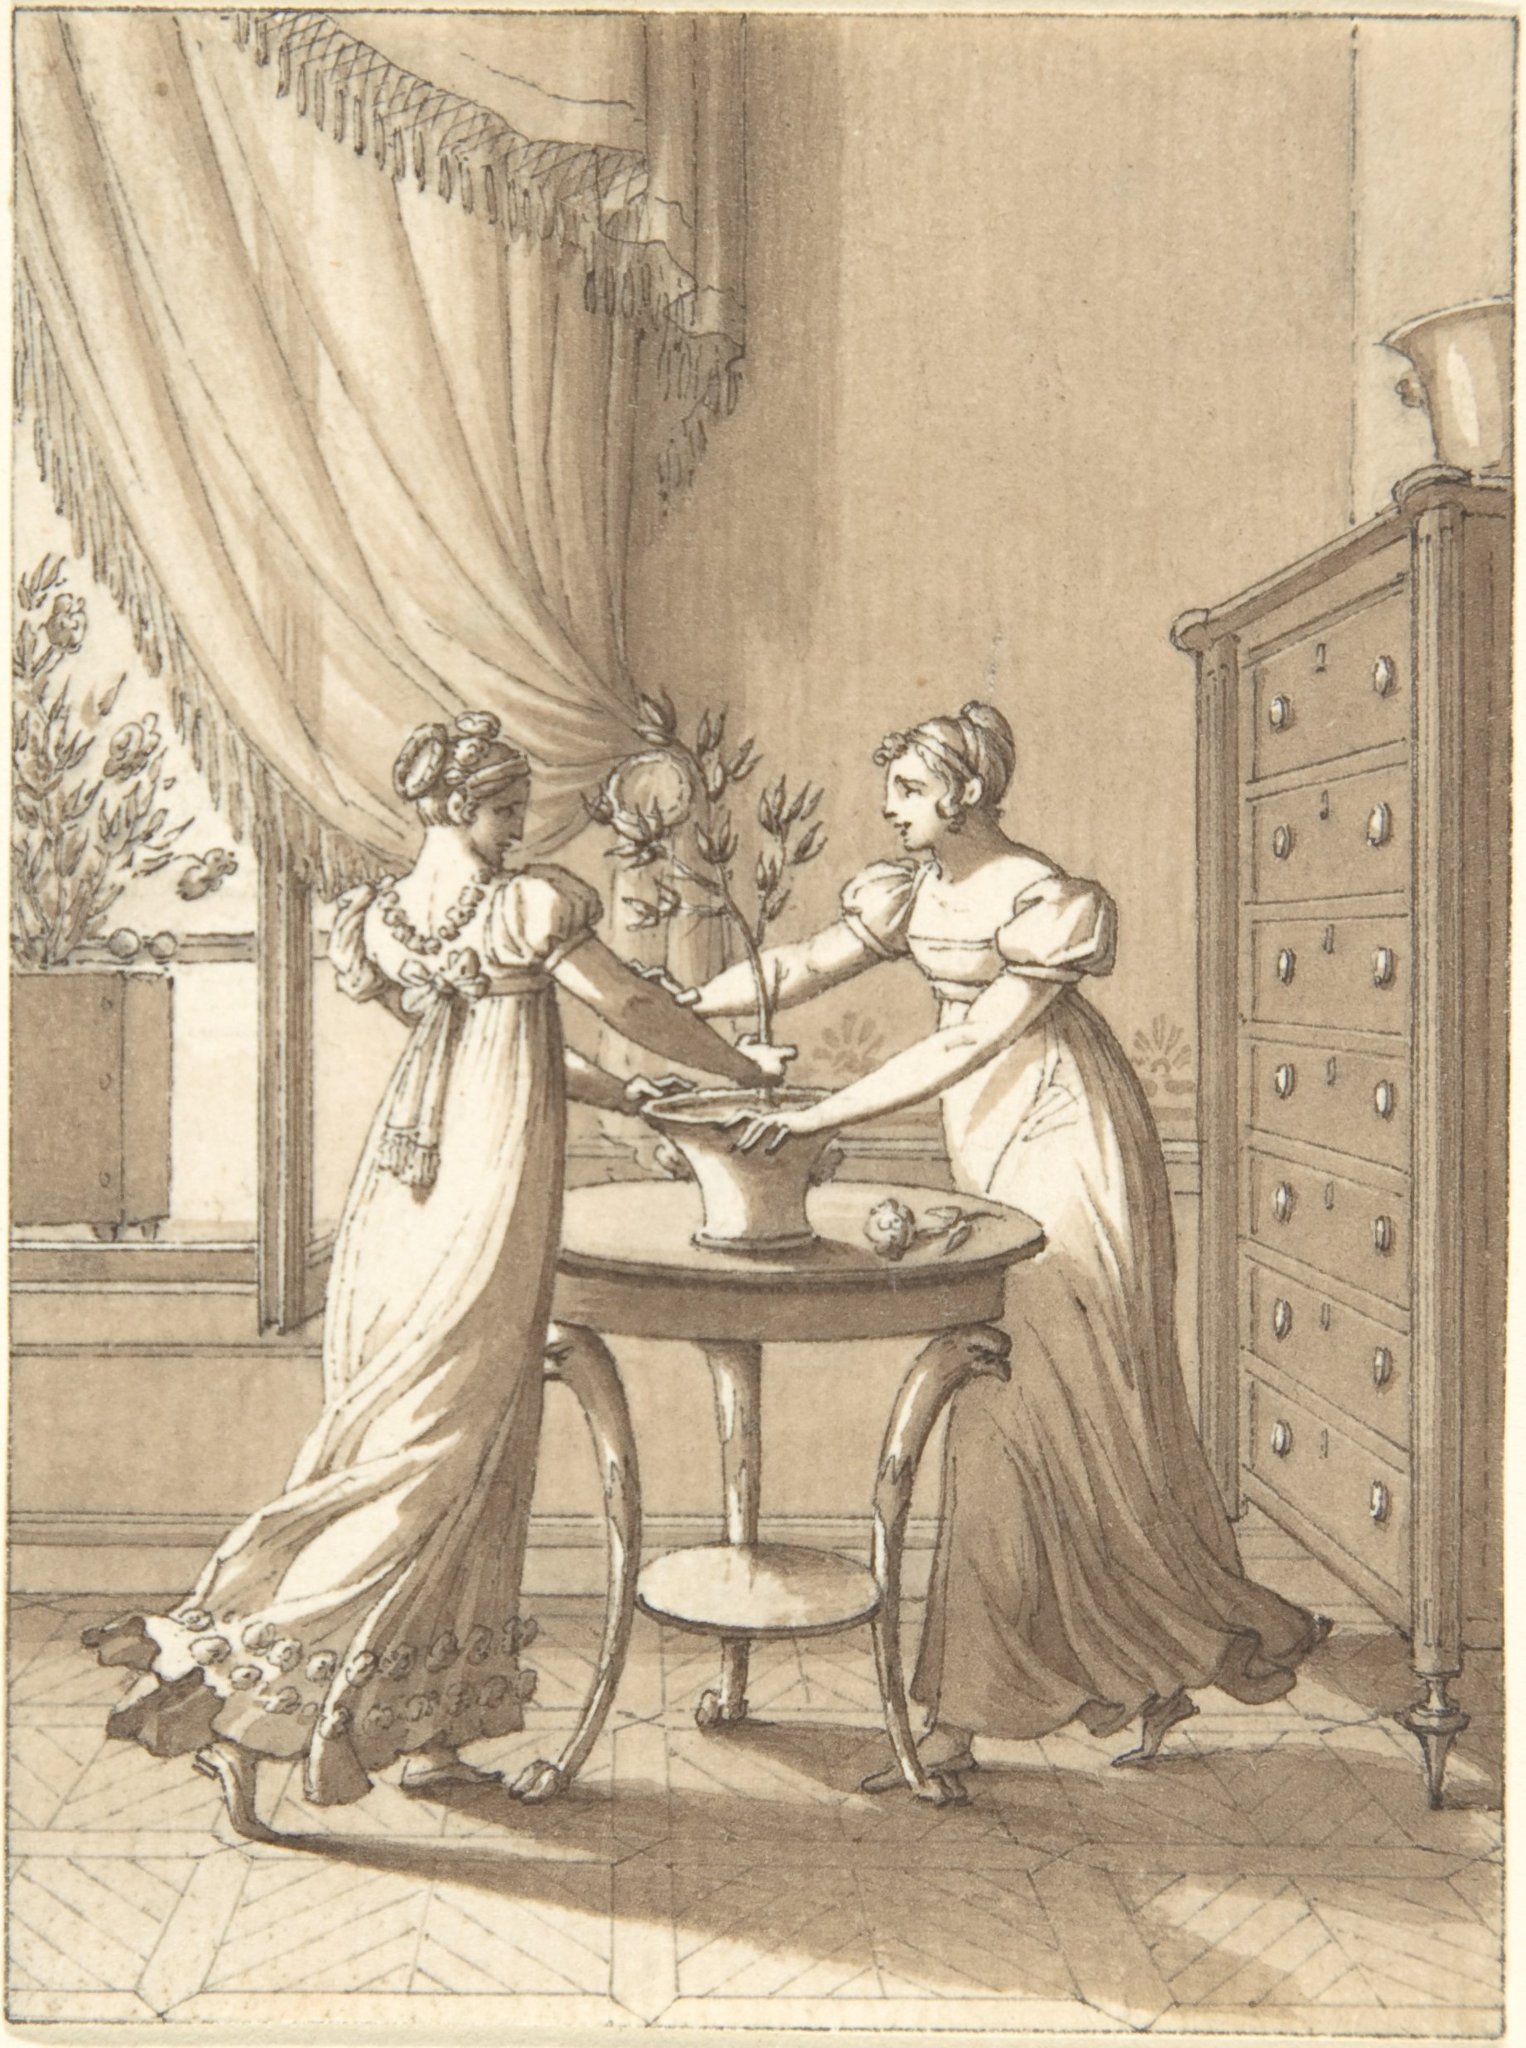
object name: drawing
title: Design for a Book Illustration: Two Women Dancing around a Plant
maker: anonymous, german, 19th century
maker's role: artist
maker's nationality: german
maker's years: 1800-1899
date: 1801-1900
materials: ink, paper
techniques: brush, pen, wash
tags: interiors,women,dancing